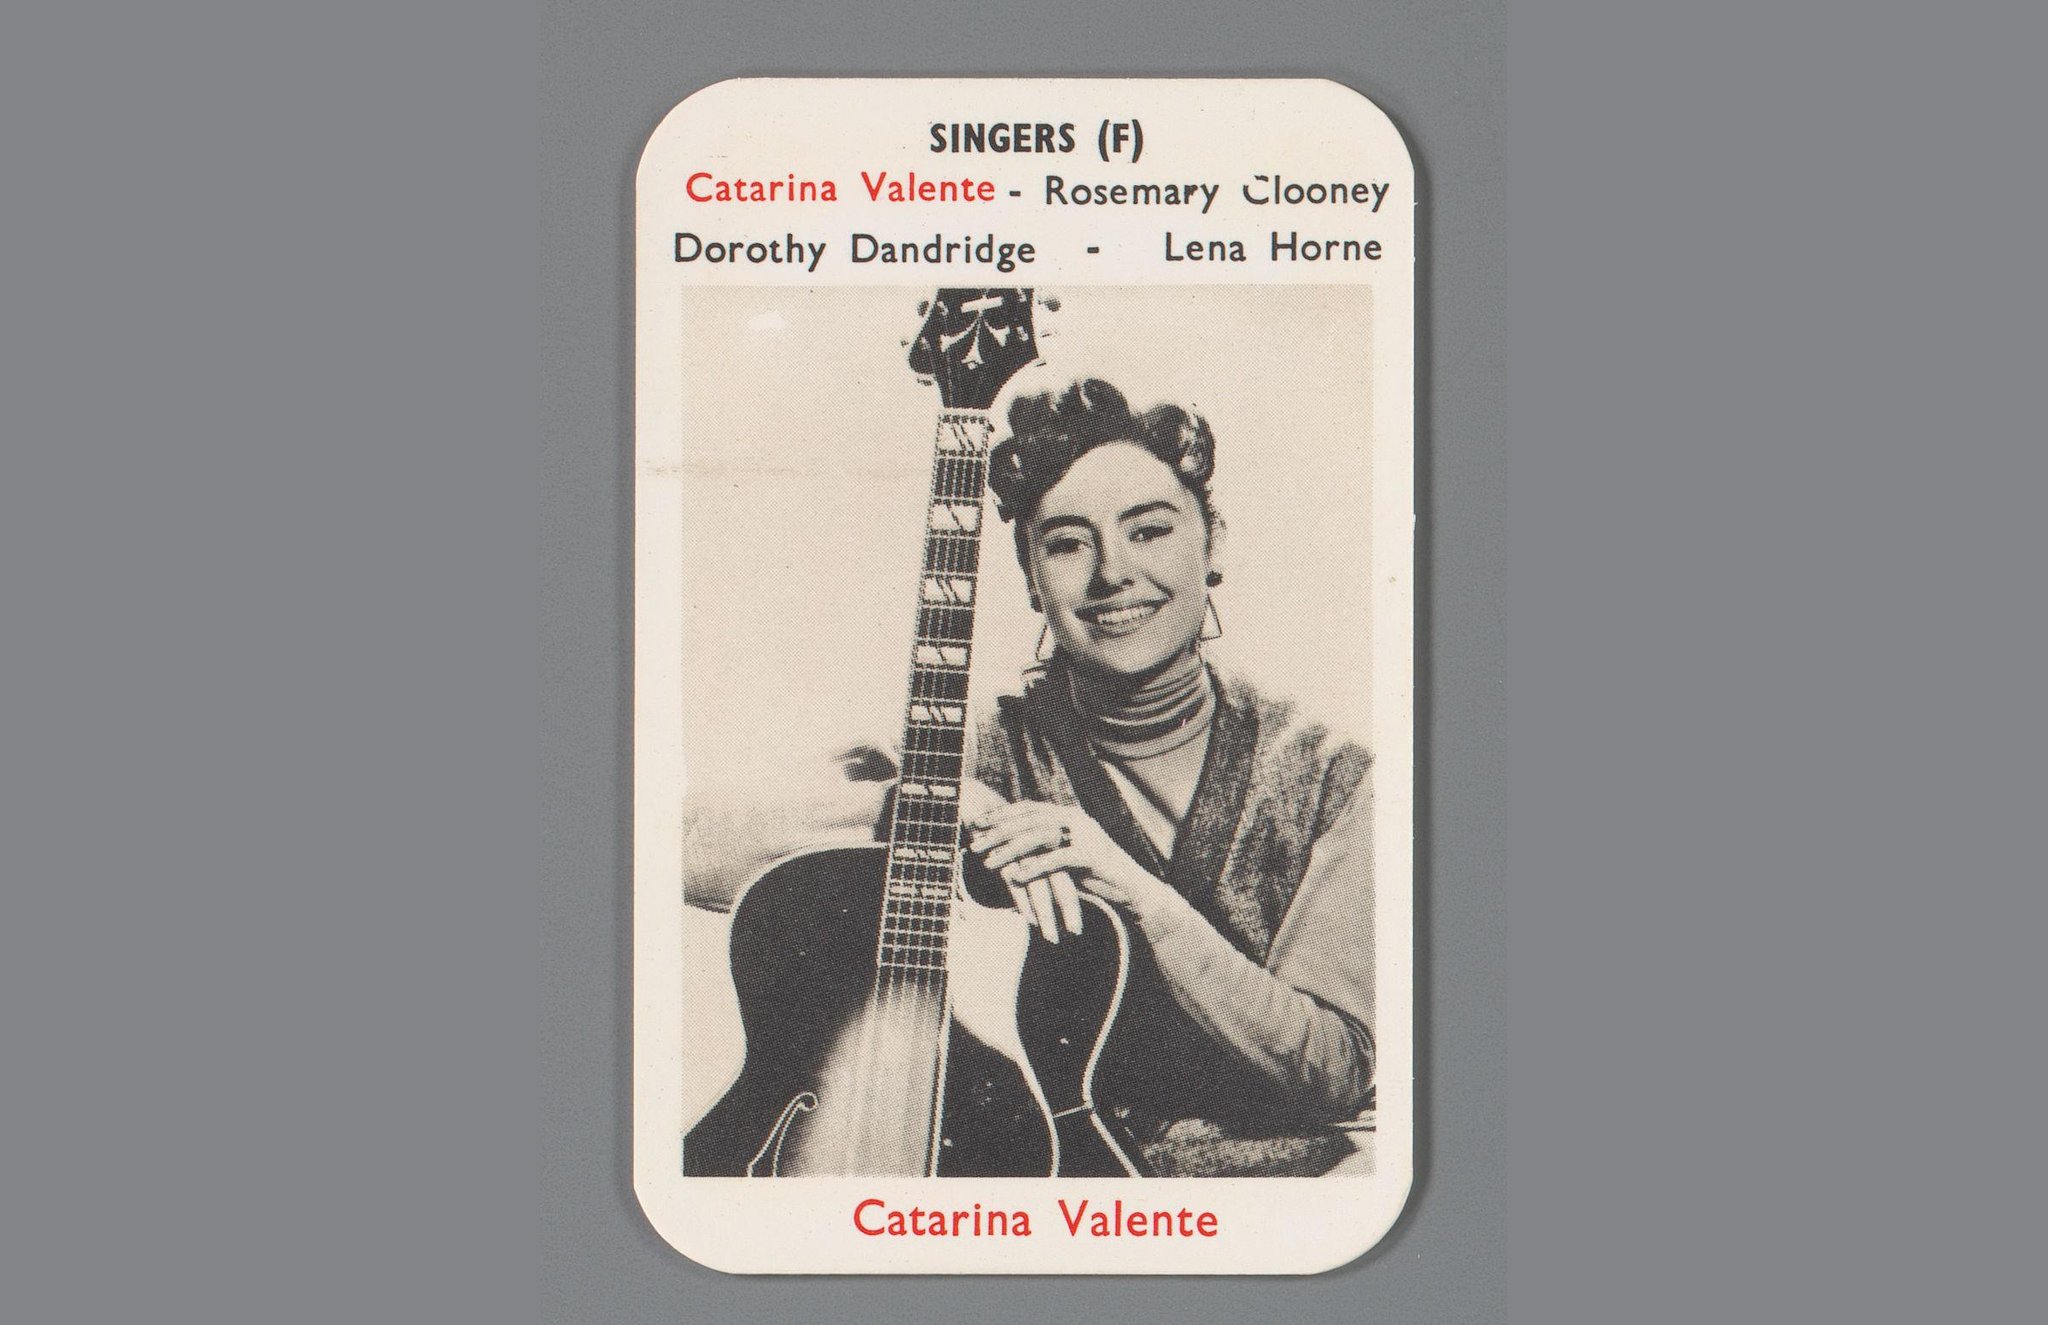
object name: playing card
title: Catarina Valente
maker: Anonymous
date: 1960-1970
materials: paper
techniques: autotype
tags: musician, portrait of a musician